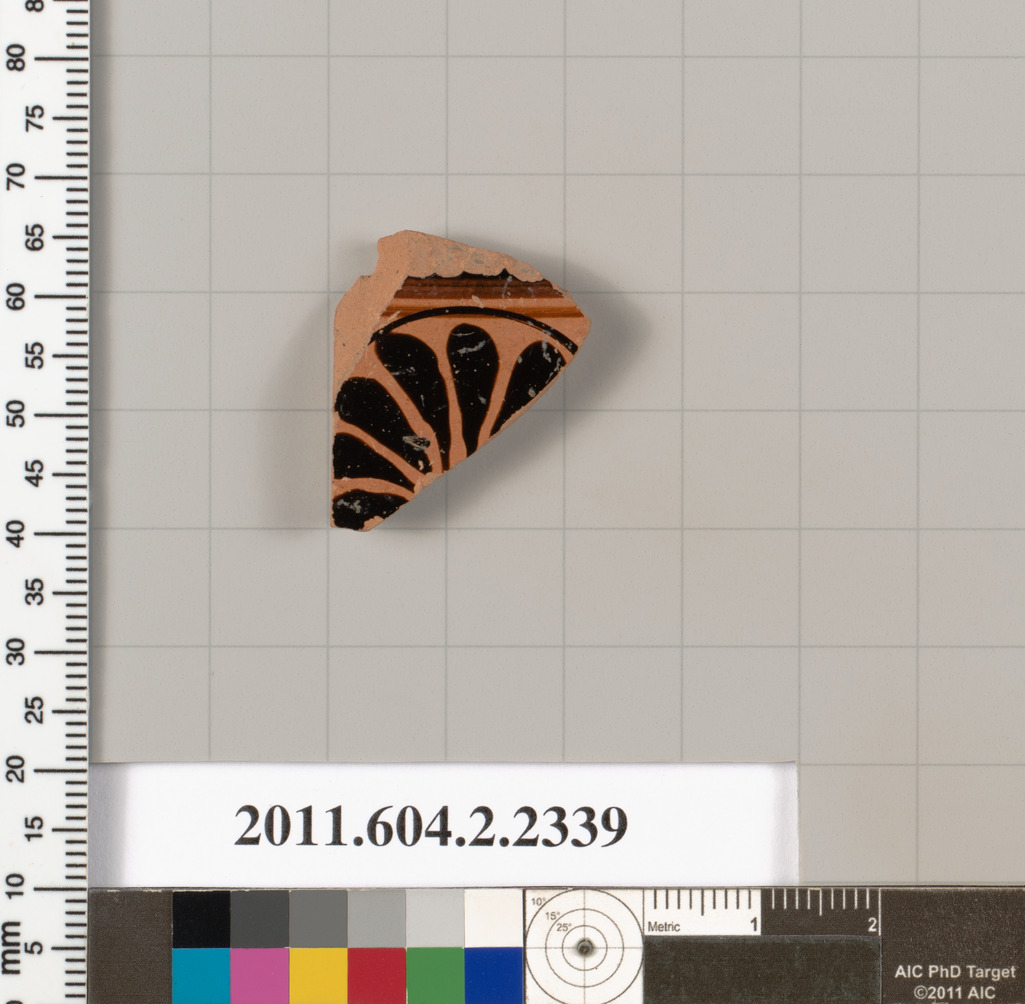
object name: stamnos fragment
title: Terracotta fragment of a stamnos (jar)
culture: greek, attic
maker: euphronios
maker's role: artist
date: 520-510 BCE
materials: terracotta